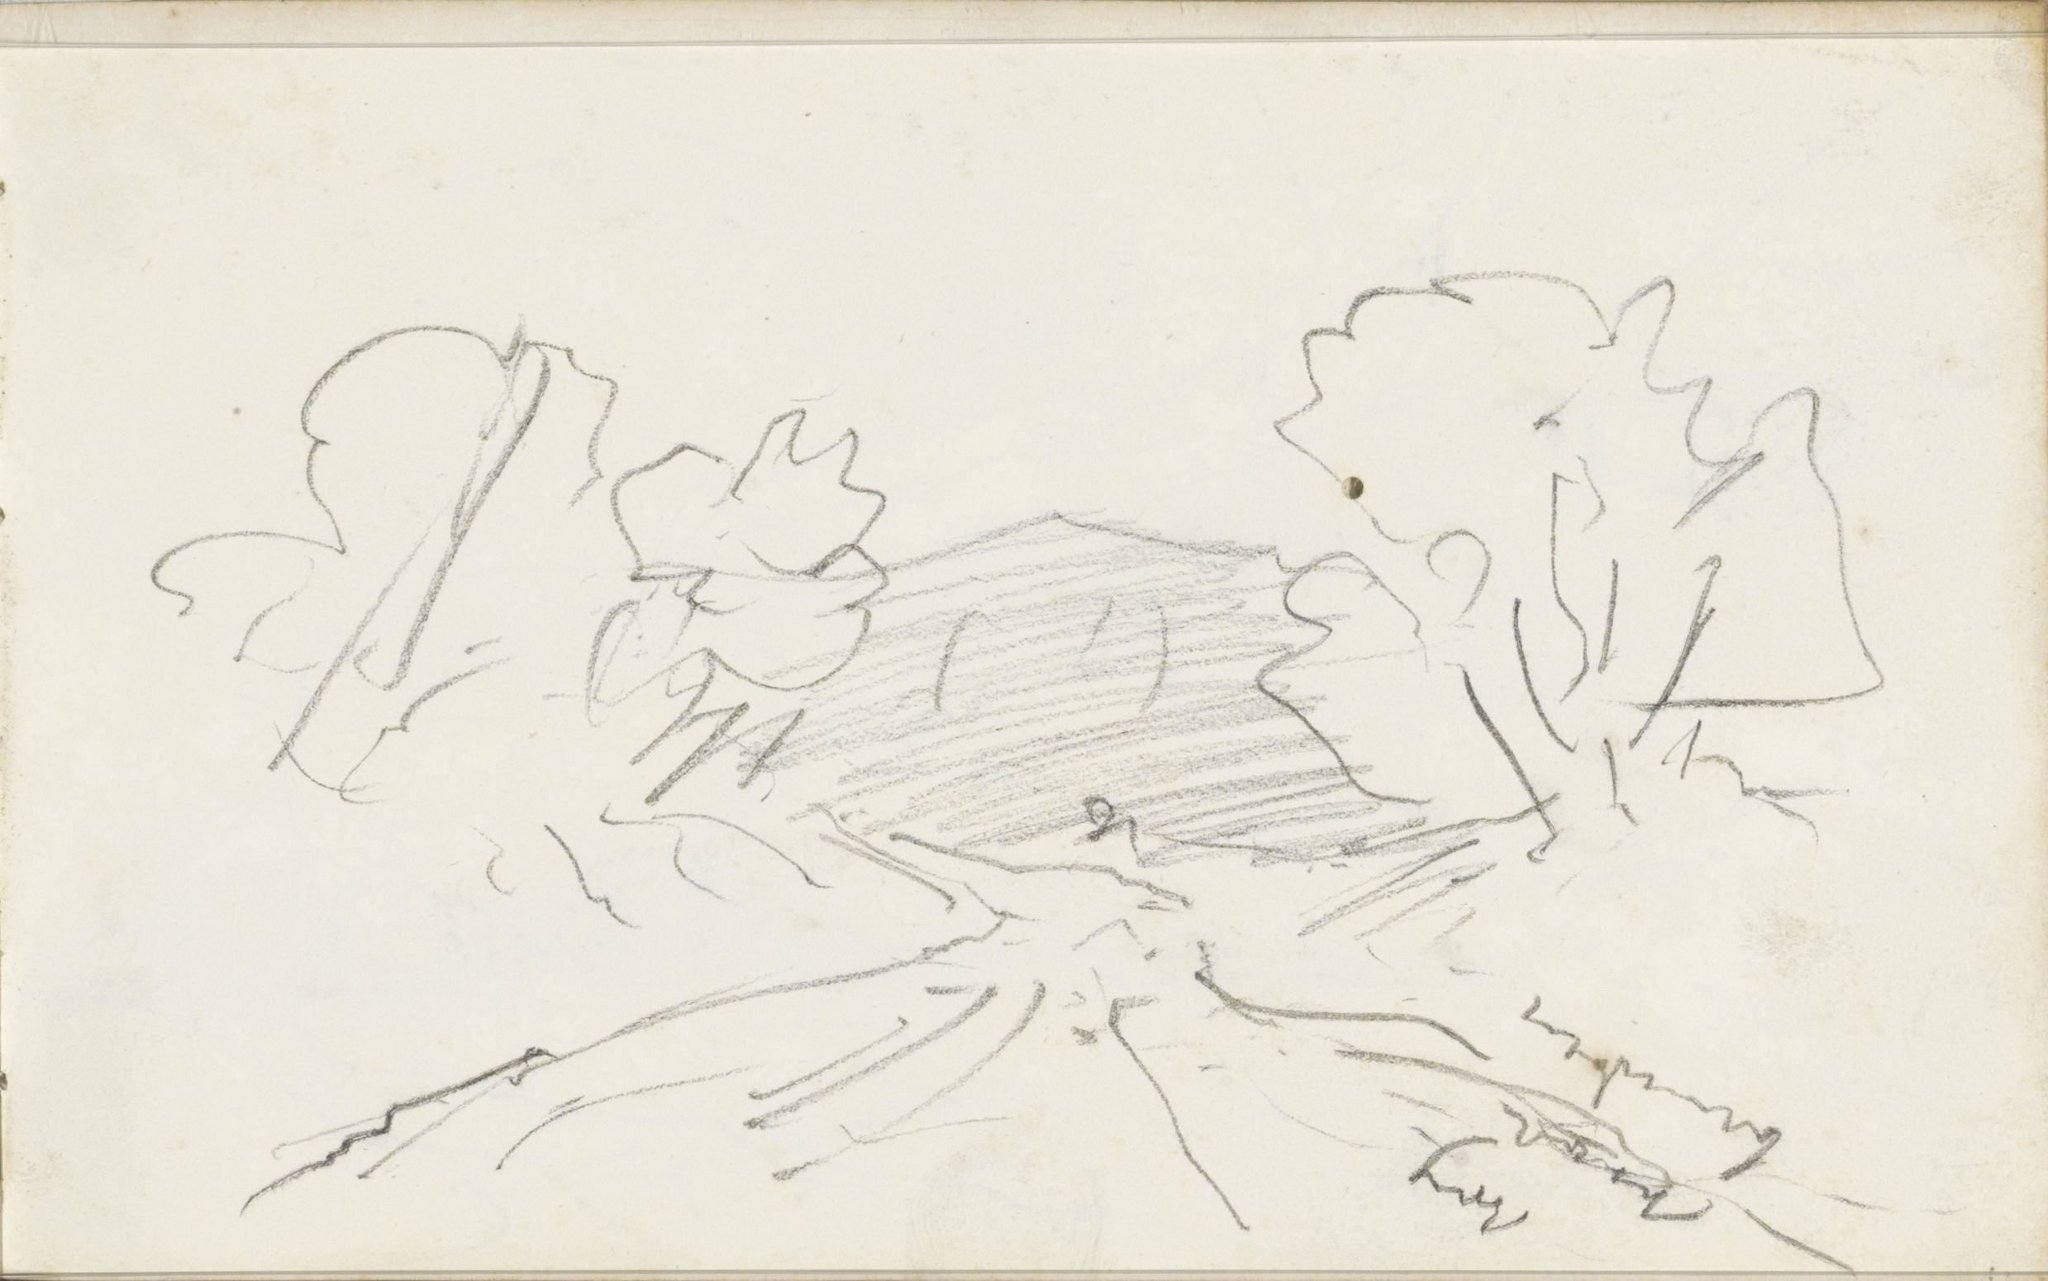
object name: sketchbook leaf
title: Heuvellandschap met een bospad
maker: johannes tavenraat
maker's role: draughtsman, painter, print maker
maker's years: 1809-1881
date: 1840-1841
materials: paper, pencil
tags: low hill country, trees, road, path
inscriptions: kleurnotitie, handgeschreven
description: Blad 18 recto uit een schetsboek met 41 bladen.